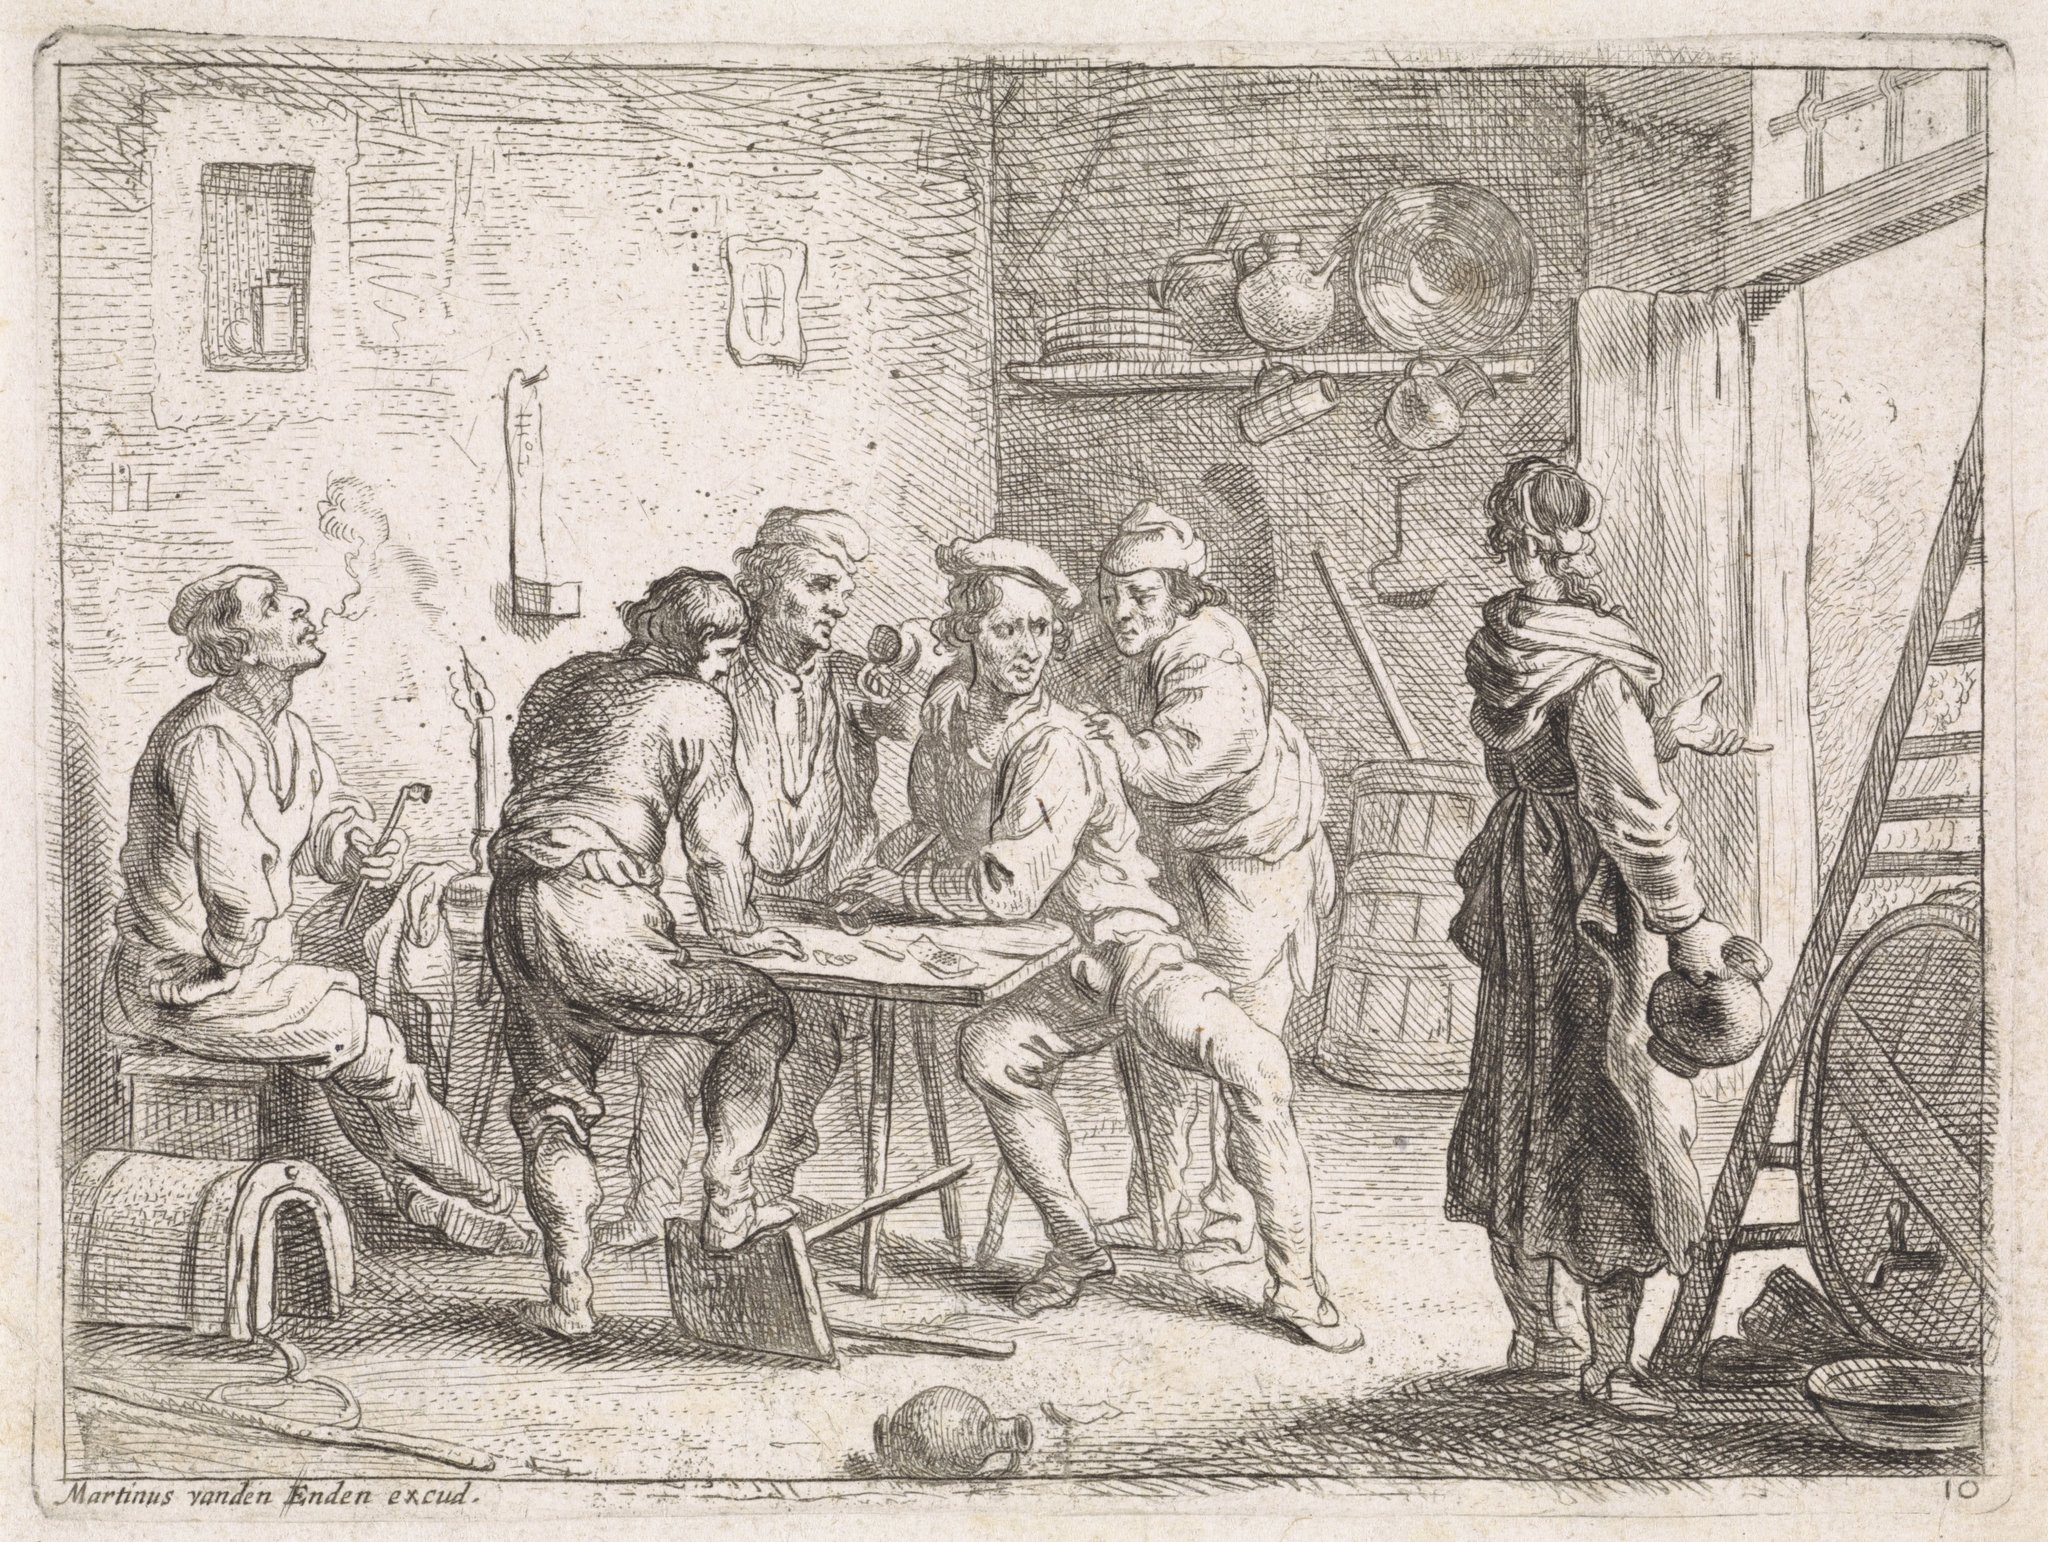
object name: print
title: Vrouw verlaat herberg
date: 1630-1654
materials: paper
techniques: engraving, etching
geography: antwerp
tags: inn, coffee-house, public house, etc., pipe ~ tobacco, drinking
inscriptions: collector's mark: Lugt 2228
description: Vijf boeren roken en drinken in een herberg. Ze kijken naar een vrouw die de herberg verlaat met een kan in haar hand.